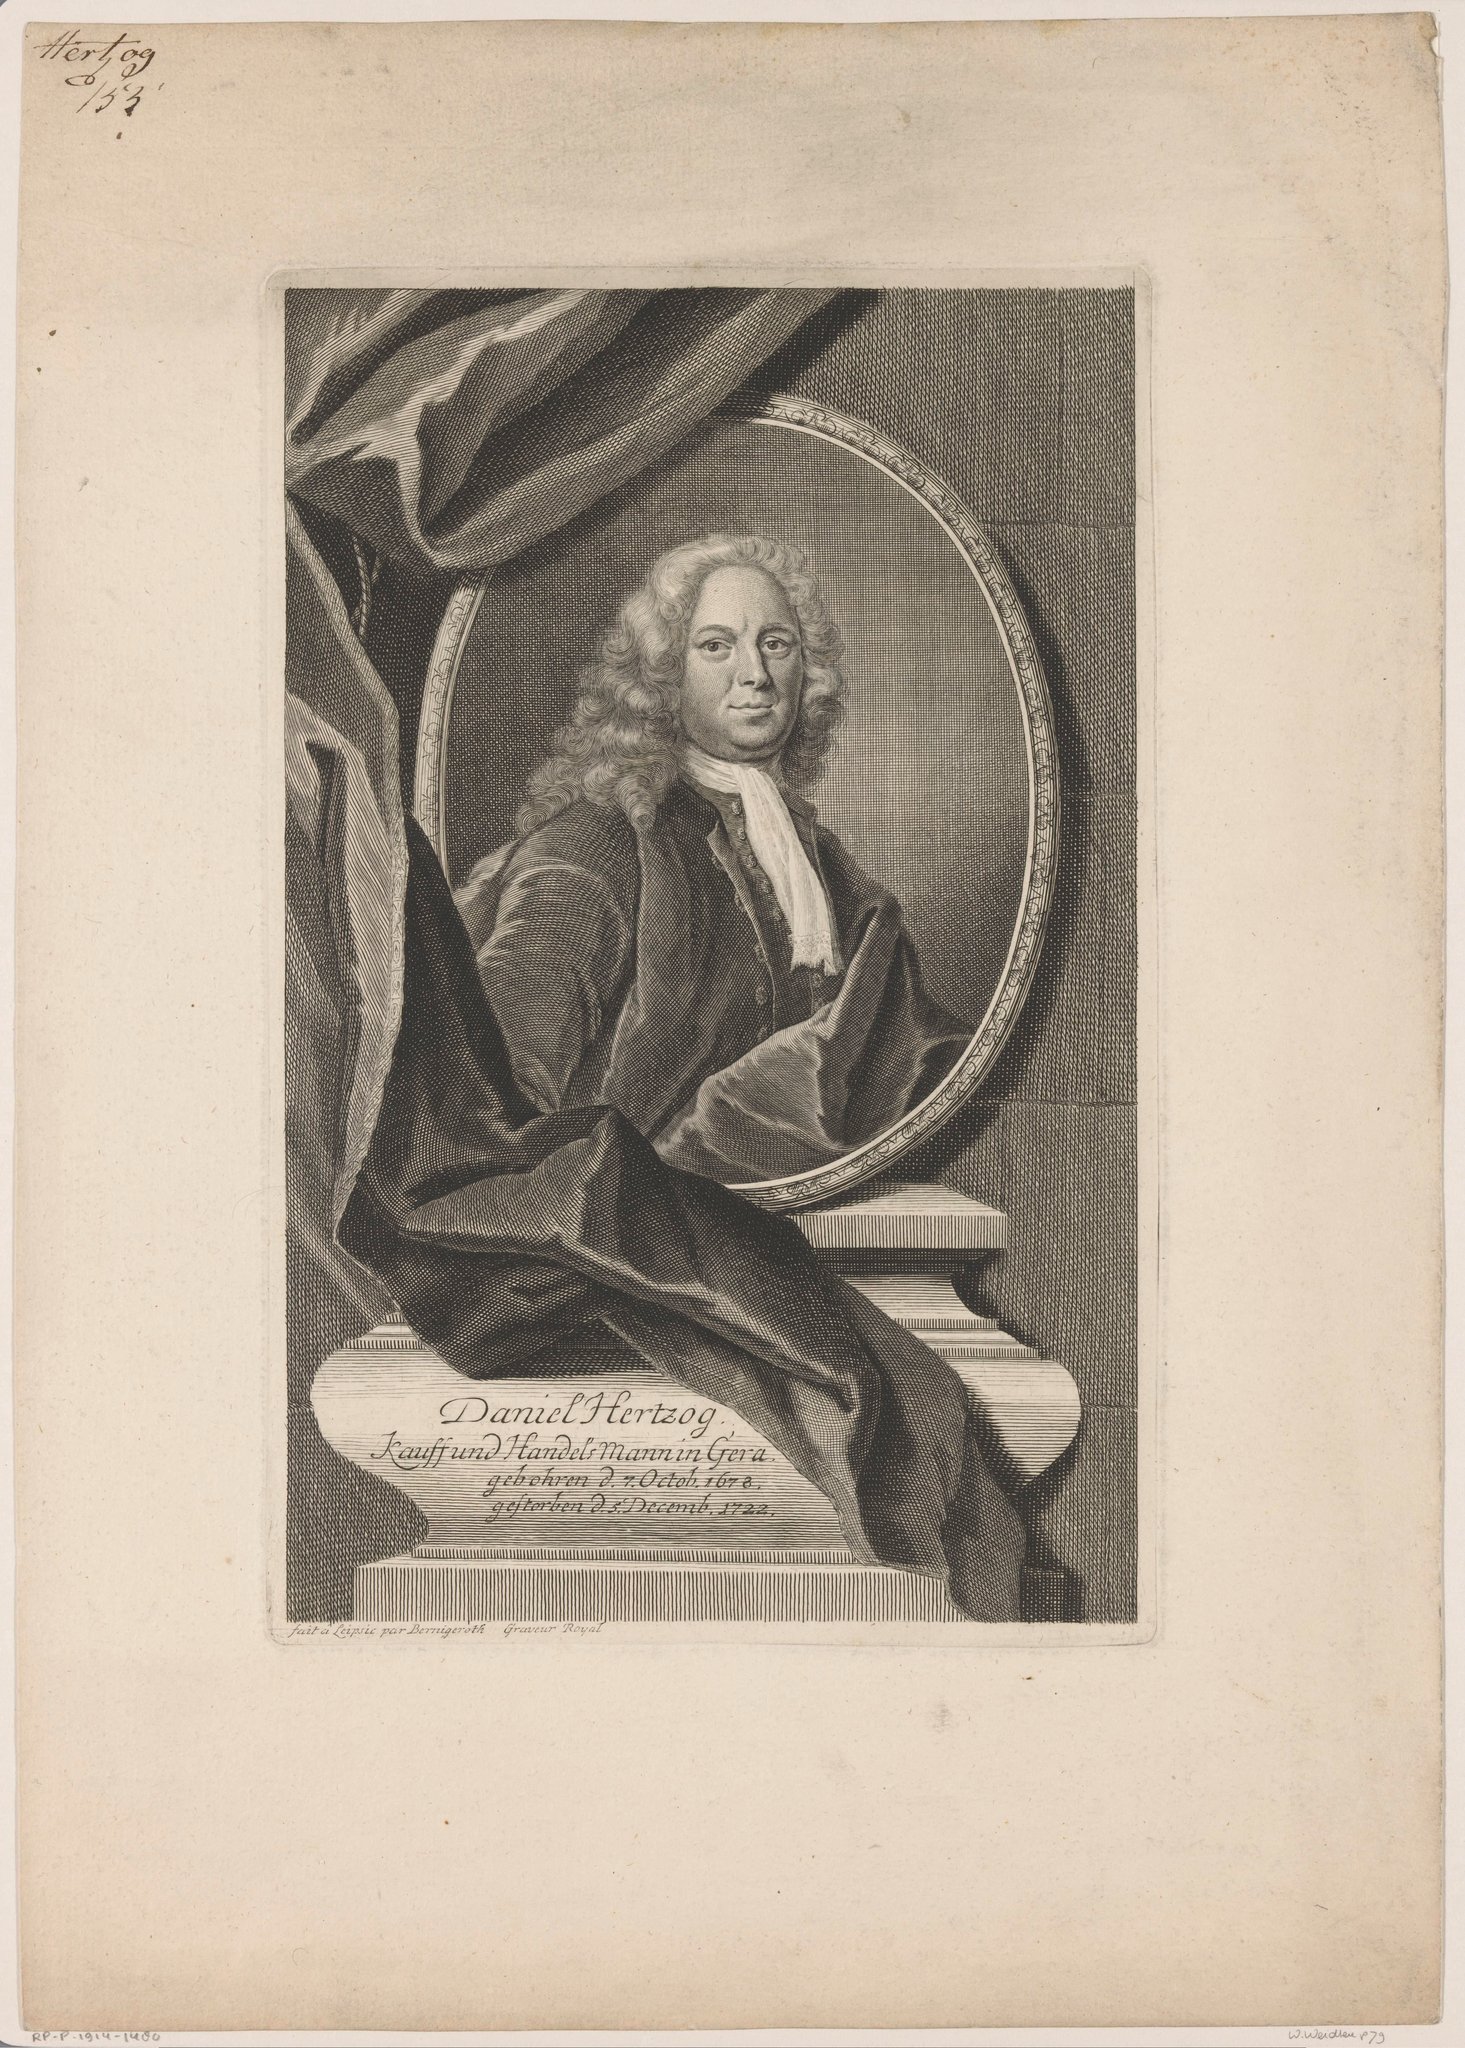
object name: print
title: Portret van Daniel Herzog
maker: martin bernigeroth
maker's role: print maker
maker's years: 1670-1733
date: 1722-1733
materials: paper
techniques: engraving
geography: leipzig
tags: historical persons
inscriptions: collector's mark: Lugt 2228